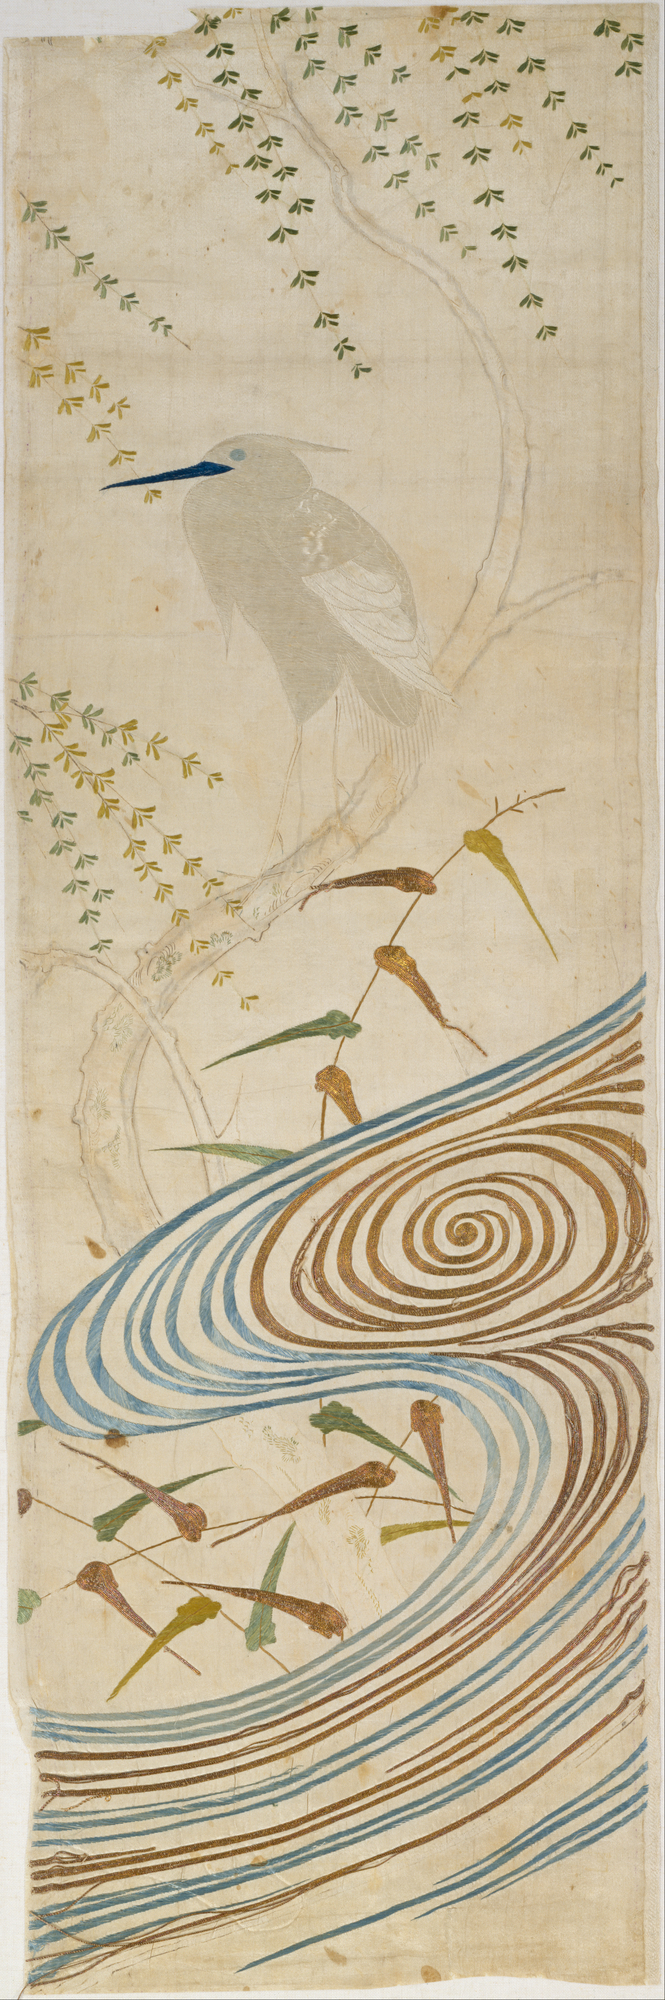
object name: noh costume piece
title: Piece from a Noh Costume (Nuihaku) with Egret (Sagi) and Willow Tree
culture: japanese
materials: silk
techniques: embroidery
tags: birds,trees